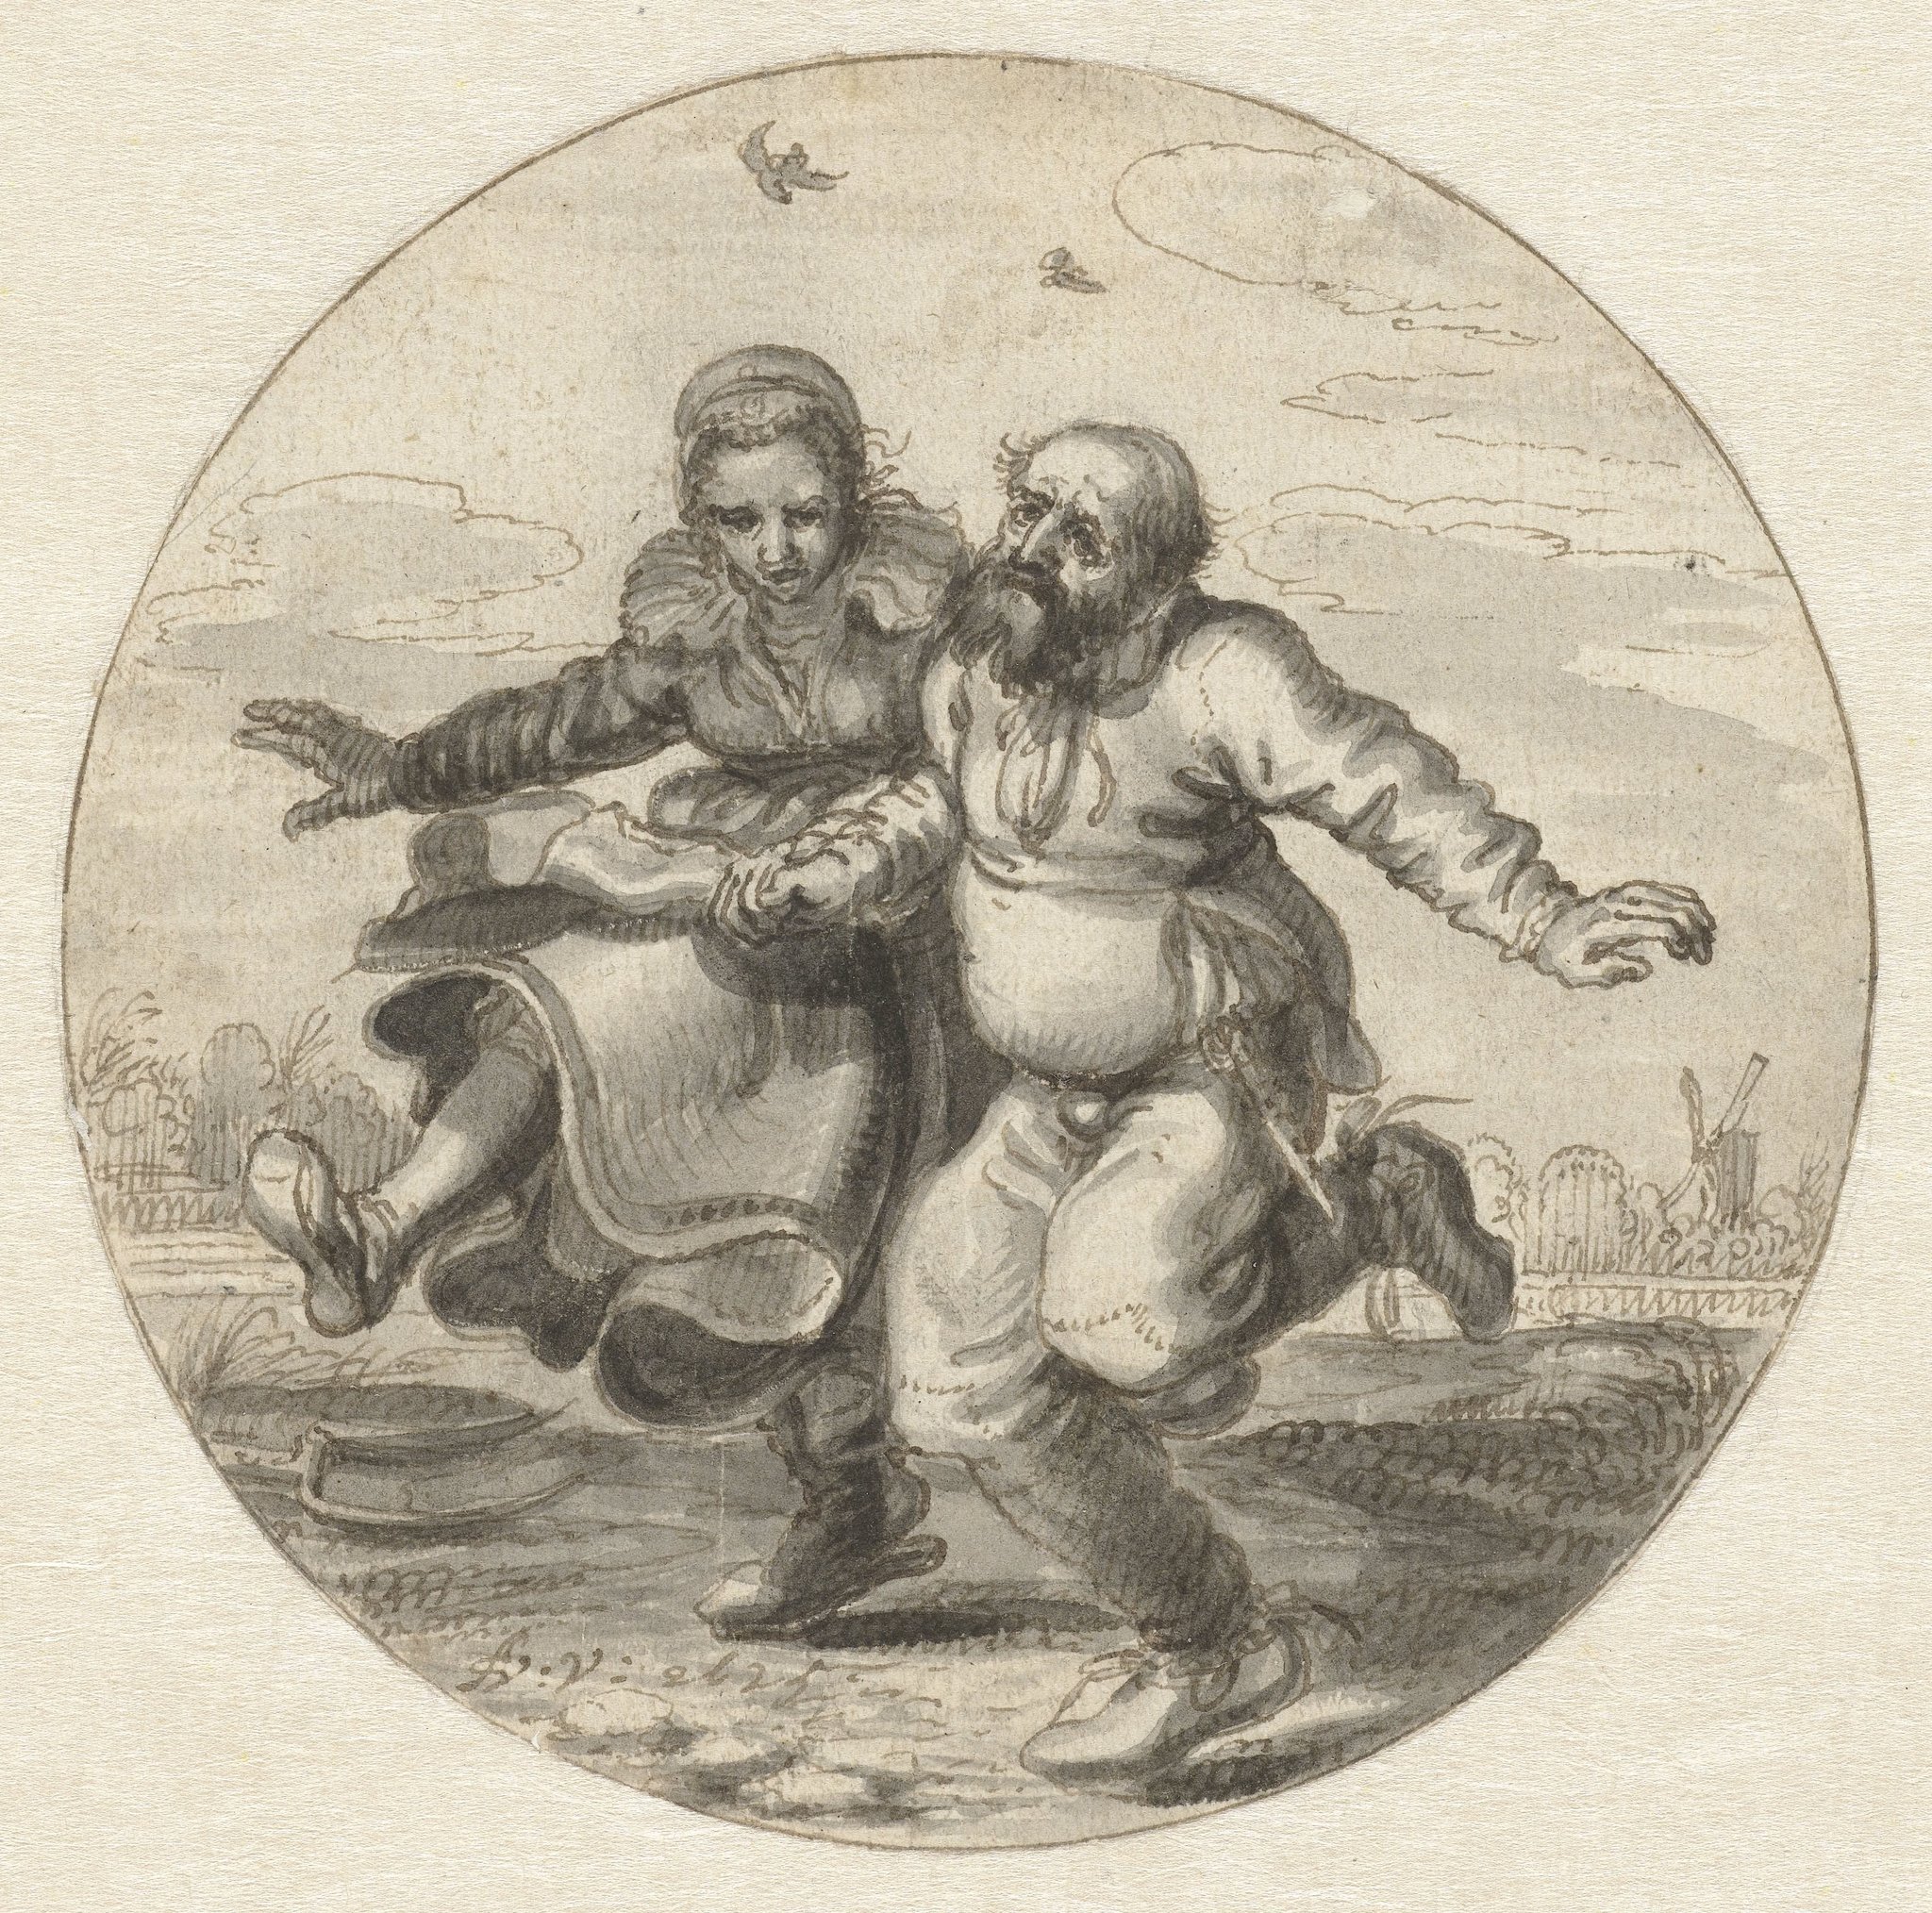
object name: drawing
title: Elderly Man Dancing with a Younger Woman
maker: adriaen pietersz van de venne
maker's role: draughtsman, painter, print maker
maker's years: 1589-1662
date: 1625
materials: chalk, ink, paper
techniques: brush, pen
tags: one pair dancing; man and woman dancing as a couple, farmers, farmers - aa - female farmer, farmer's wife